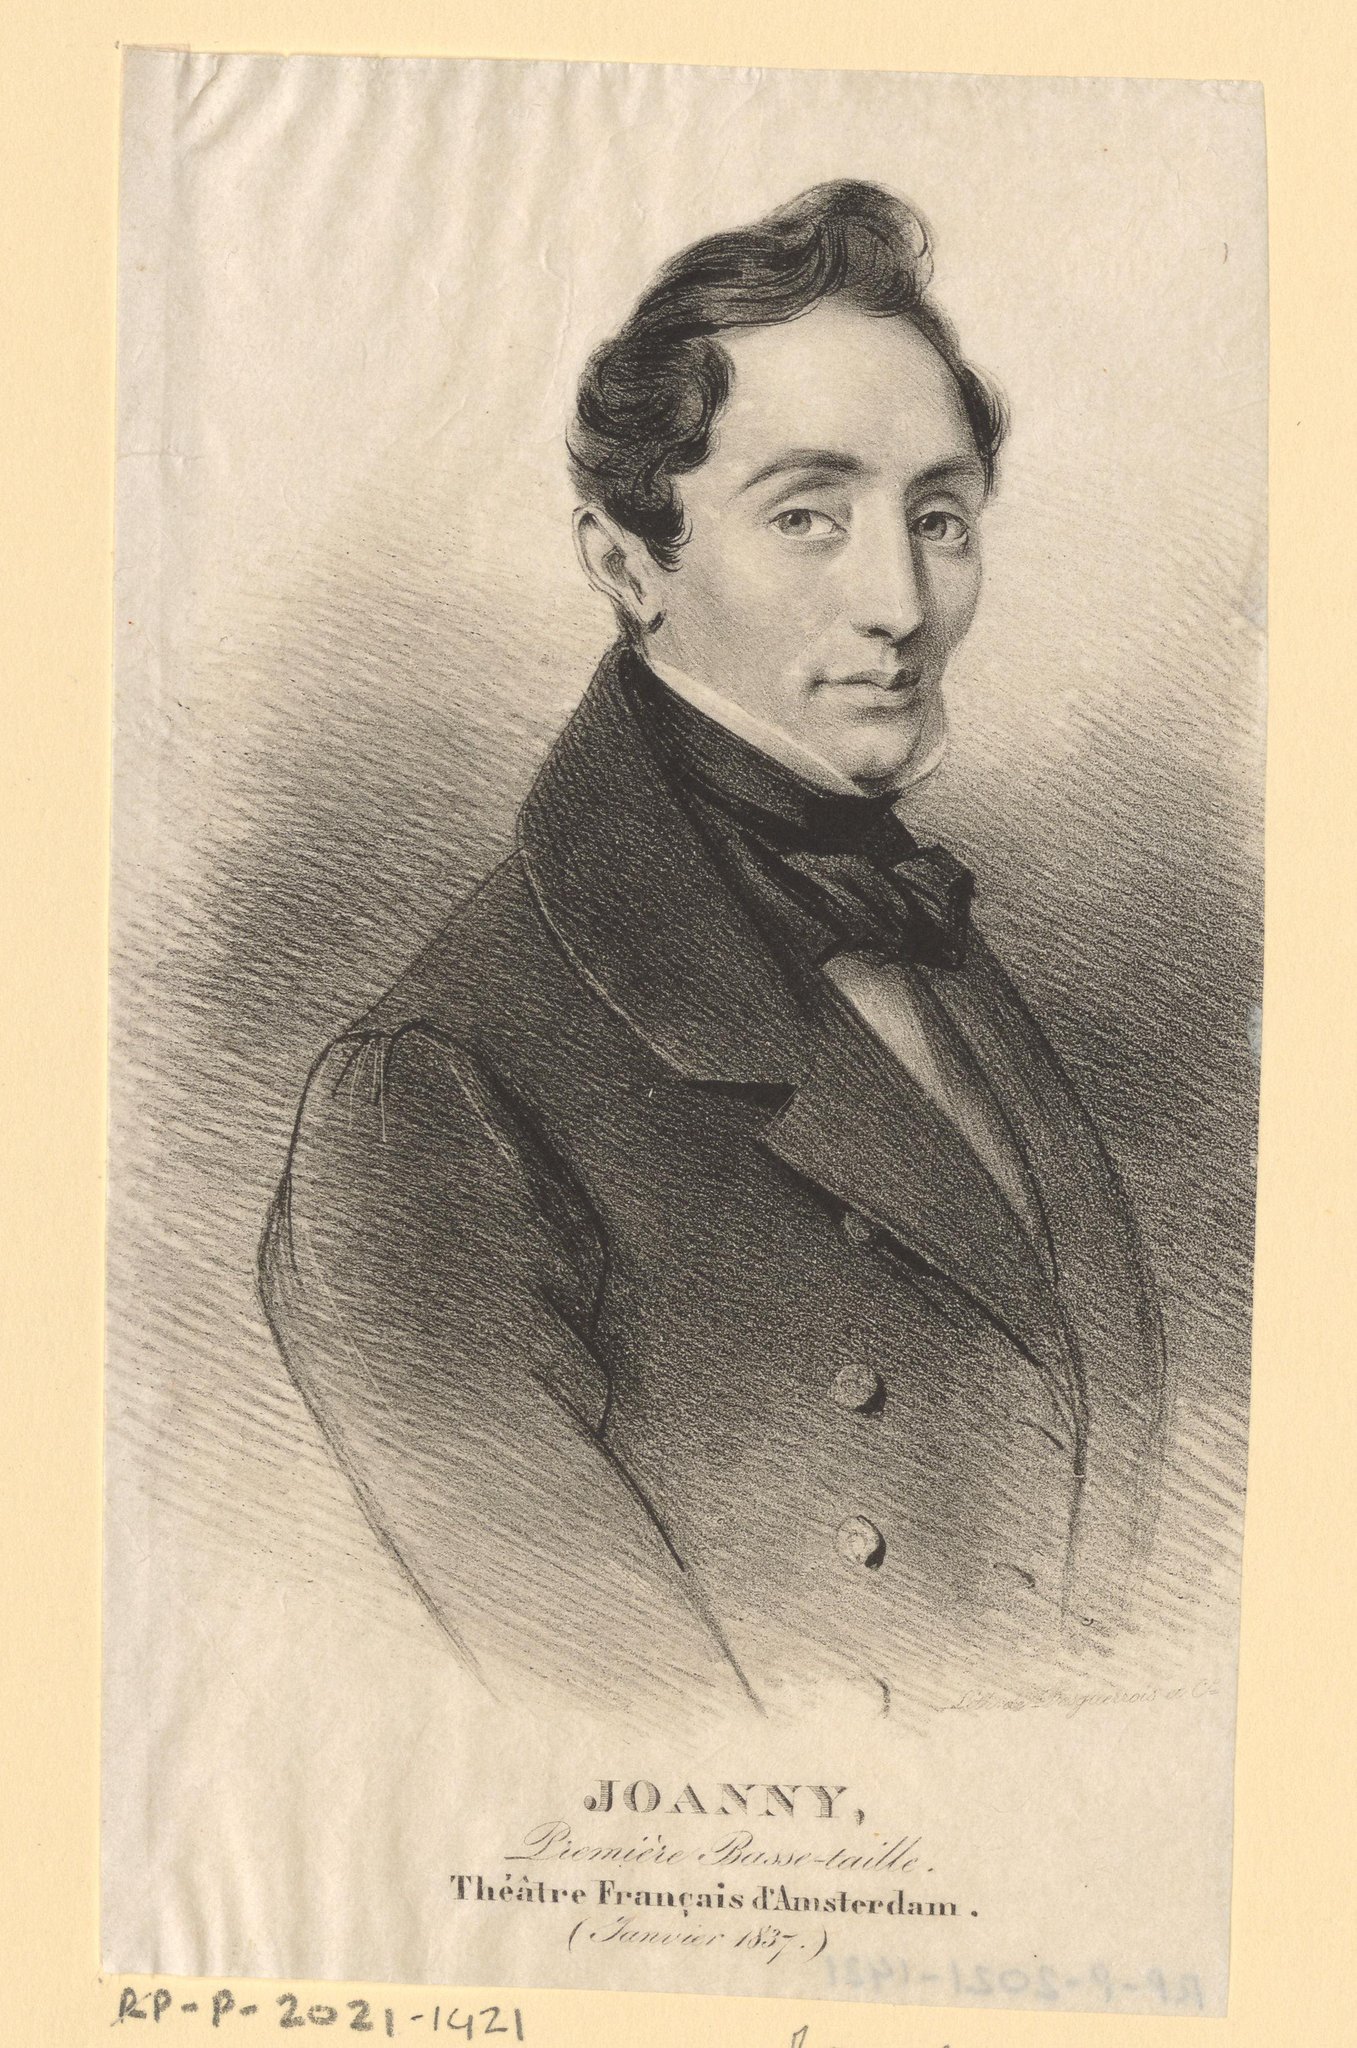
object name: print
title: Portret van Joanny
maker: Anonymous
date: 1837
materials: paper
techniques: lithograph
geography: amsterdam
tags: historical persons, portrait of actor, actress